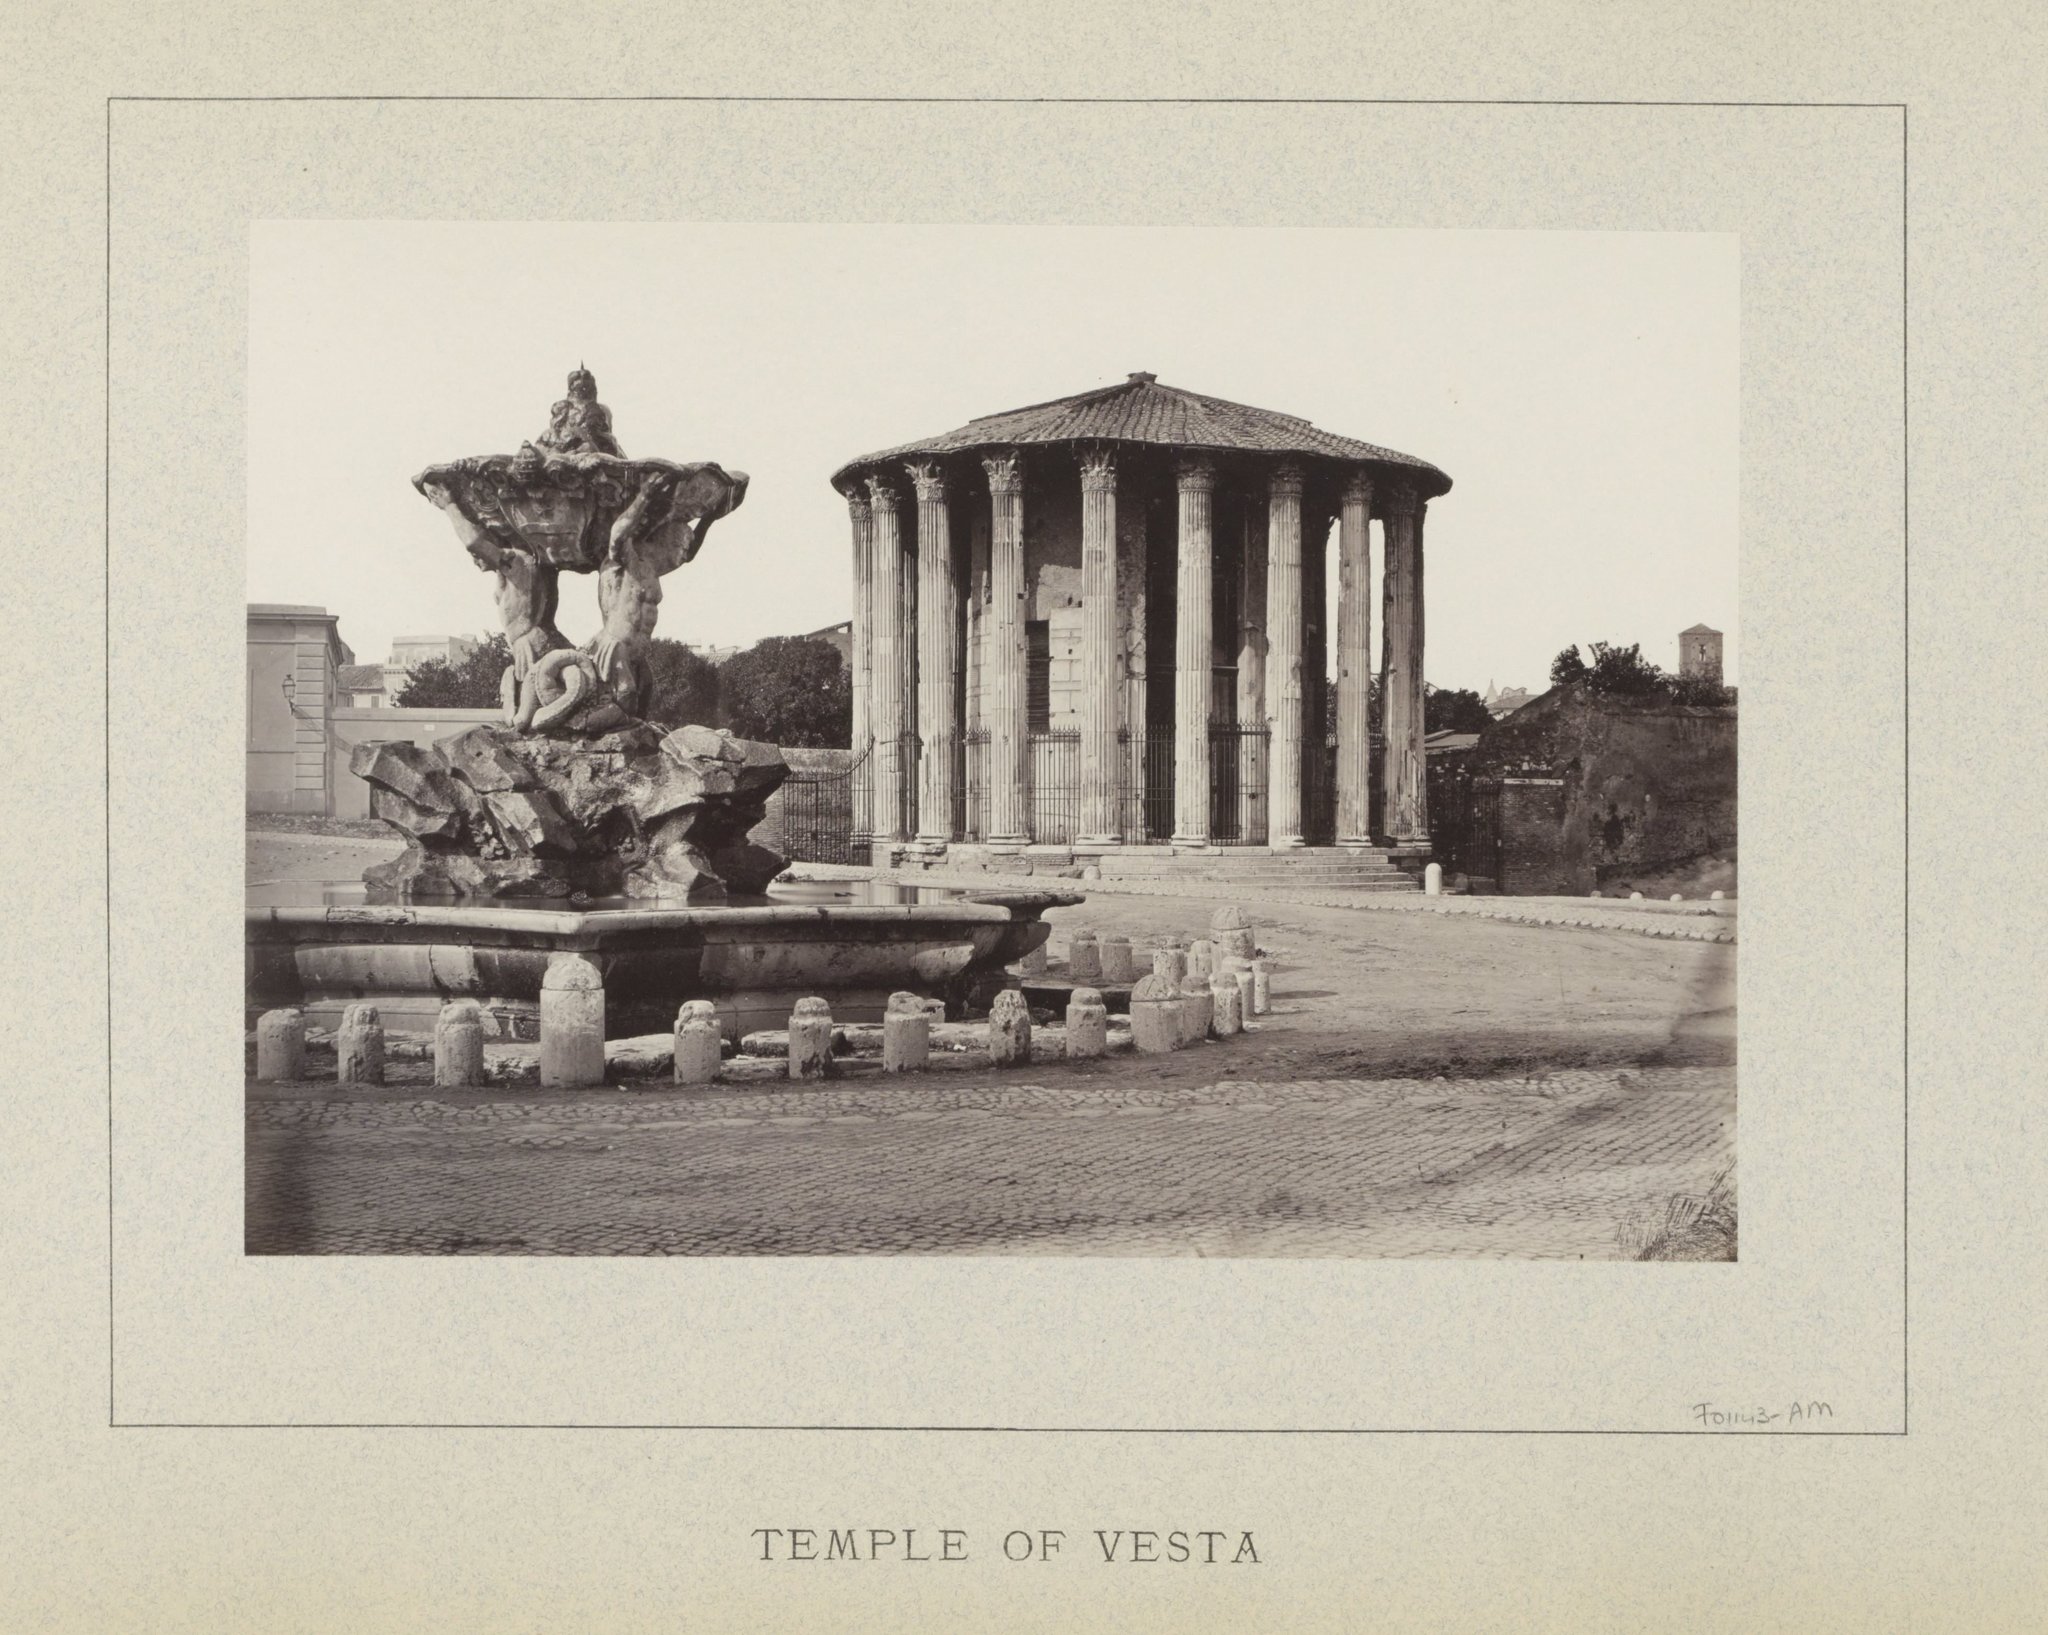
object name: photograph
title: Tempel van Hercules Invictus in Rome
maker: Anonymous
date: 1860-1900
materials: photographic support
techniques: albumen print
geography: rome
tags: temple, shrine ~ roman religion, ornamental fountain (+ city(-scape) with figures, staffage)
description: Onderdeel van Fotoalbum met opnames van bezienswaardigheden en kunstwerken in Rome.